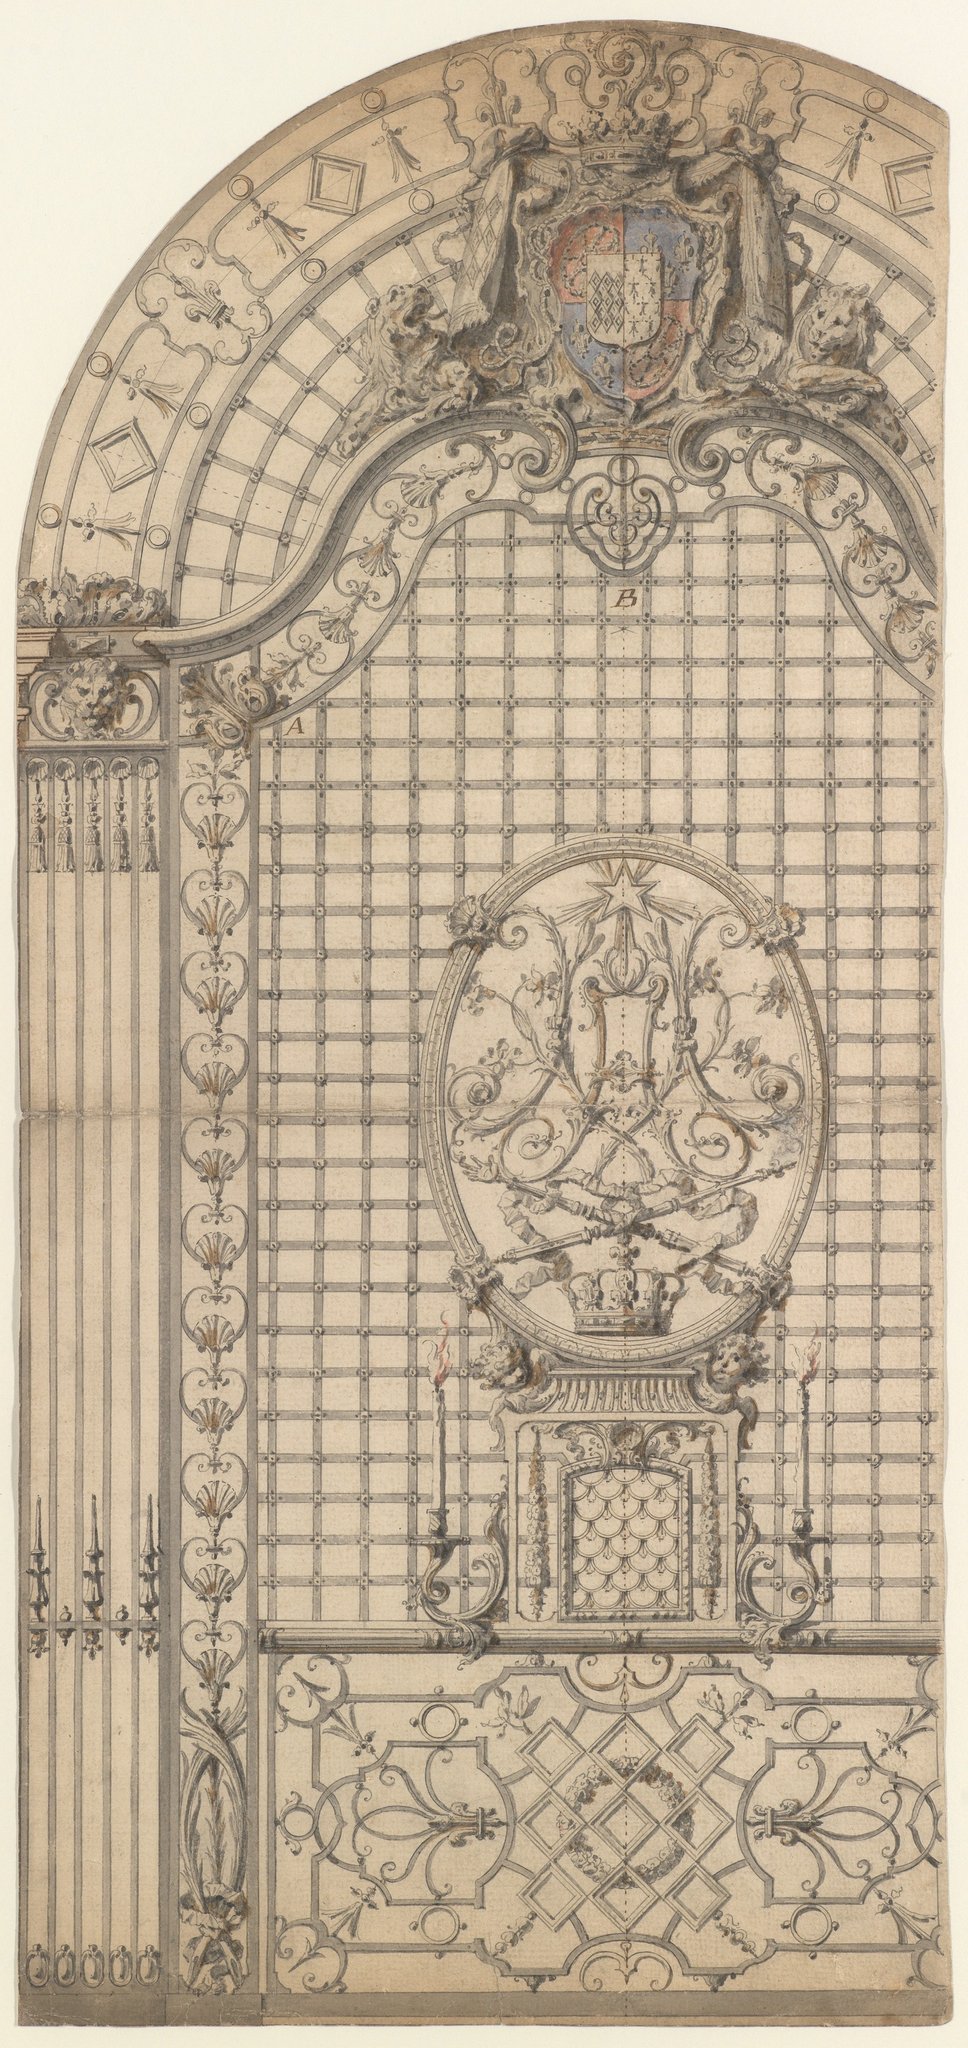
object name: drawing collection ornament architecture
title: Design for the Wrought-Iron Entrance Grille of a Chapel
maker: gilles-marie oppenord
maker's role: artist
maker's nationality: french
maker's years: 1672-1742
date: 1700-1720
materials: ink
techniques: brush, pen, wash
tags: coat of arms